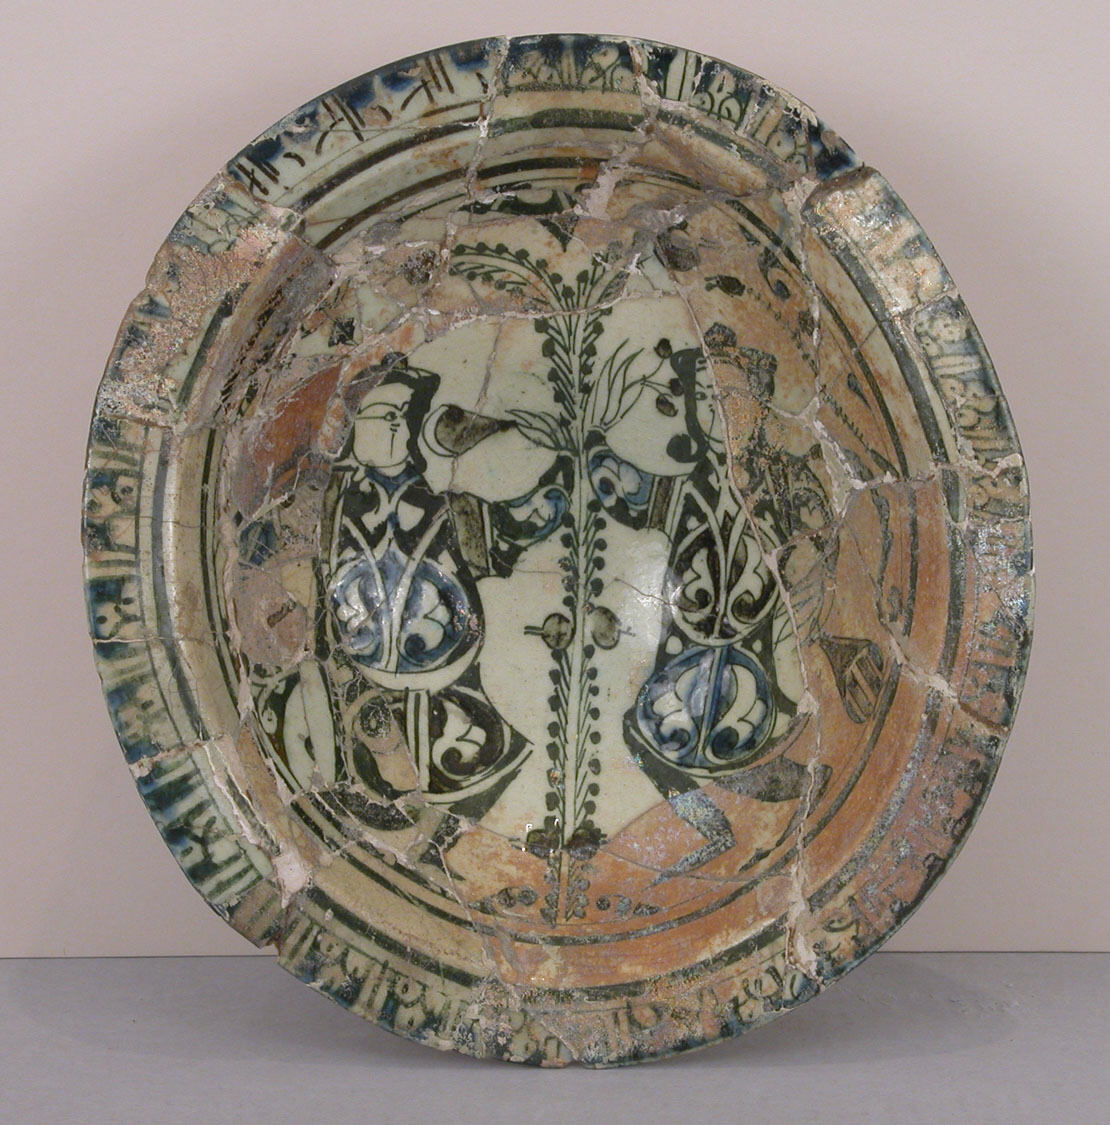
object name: bowl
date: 1201-1300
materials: stonepaste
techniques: painting, underglaze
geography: syria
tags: human figures